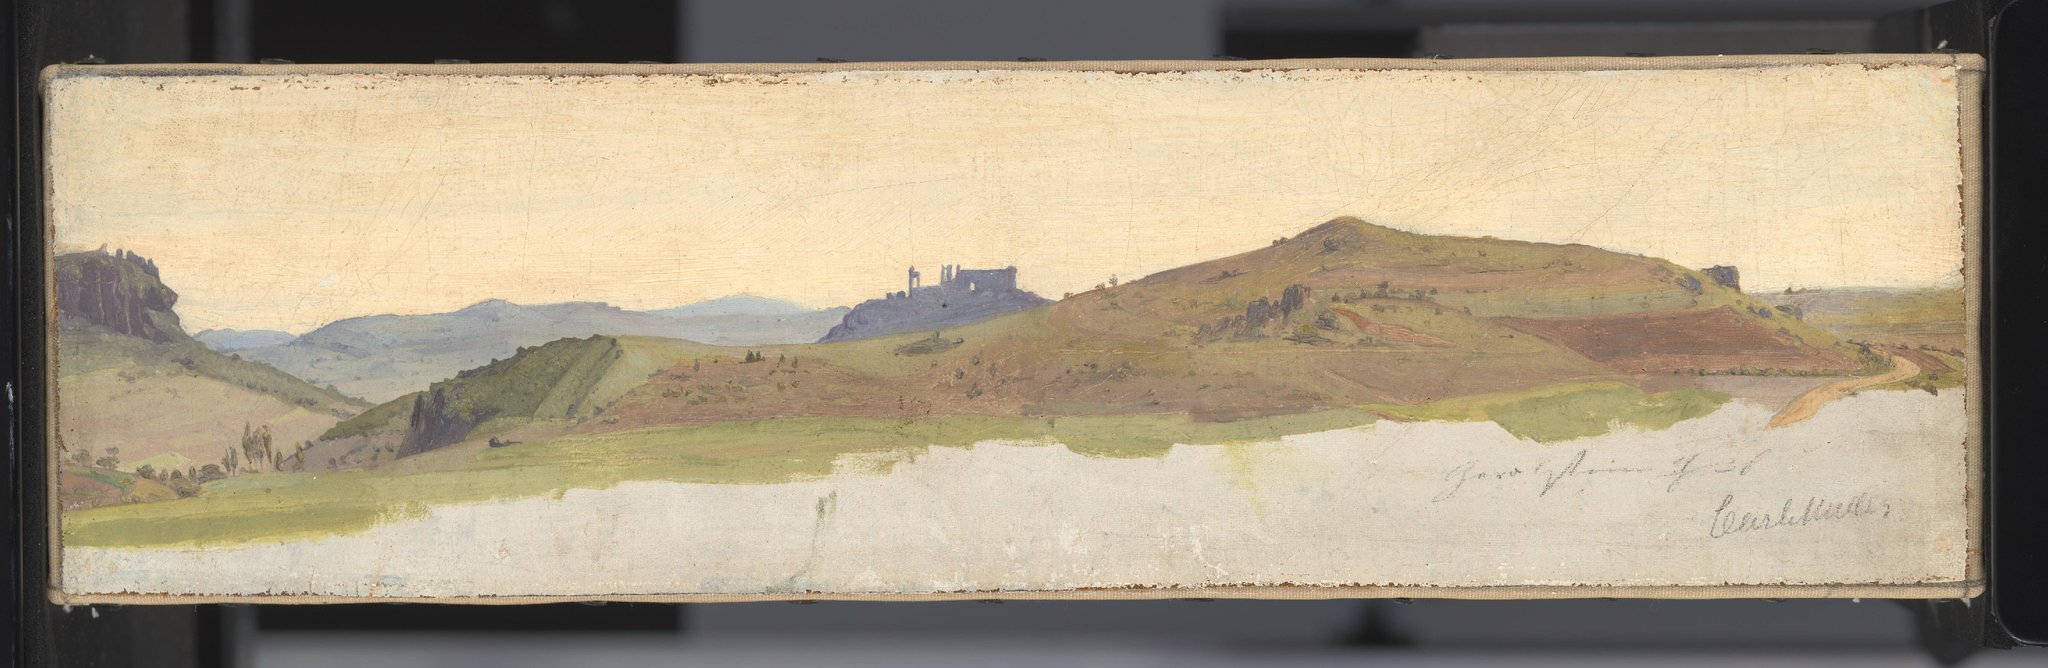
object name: oil sketch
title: Gezicht op Gerolstein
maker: carl müller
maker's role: print maker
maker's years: 1803-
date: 1836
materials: linen, oil, paint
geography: gerolstein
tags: gerolstein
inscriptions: signature and date: ‘Gerolstein, 7.6.36/Carl Müller’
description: Een panoramische blik op het gebergte bij Gerolstein in de Eiffel, Duitsland. De voorgrond is onvoltooid.